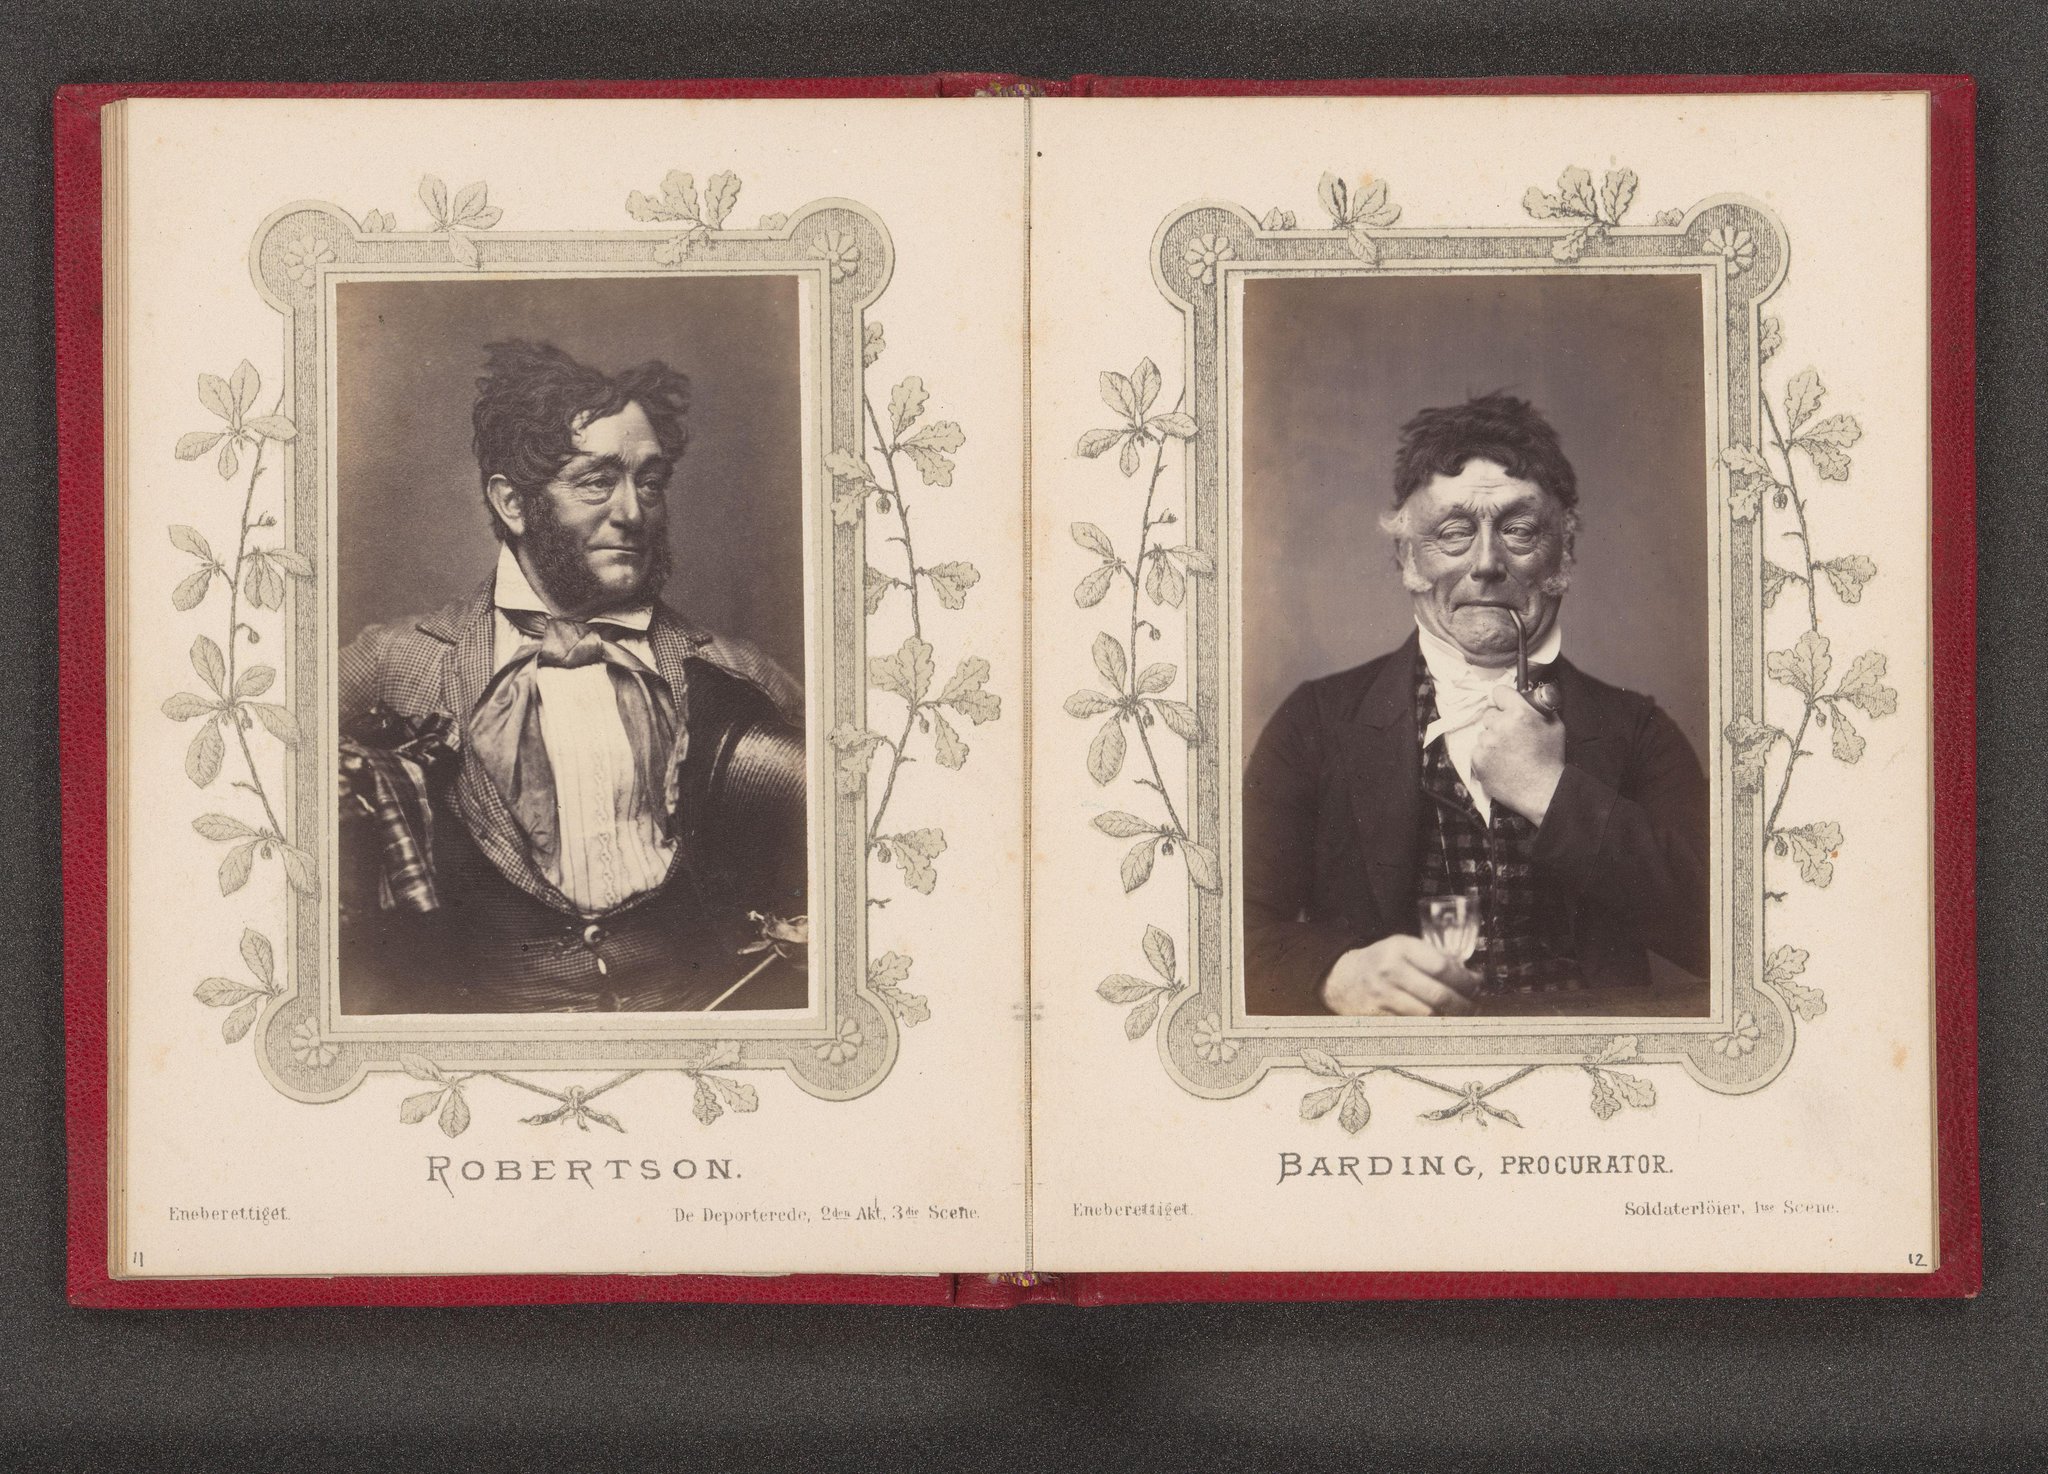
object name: page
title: Portret van Joachim Ludvig Phister als een procureur met een pijp uit Soldaterlöier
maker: harald paetz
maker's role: fotograaf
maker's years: 1837-1895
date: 1862-1872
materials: photographic support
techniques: albumen print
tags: stage costume, portrait of actor, actress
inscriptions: inscription: ‘Eneberettiget Soldaterlöier, 1ste Scene.’